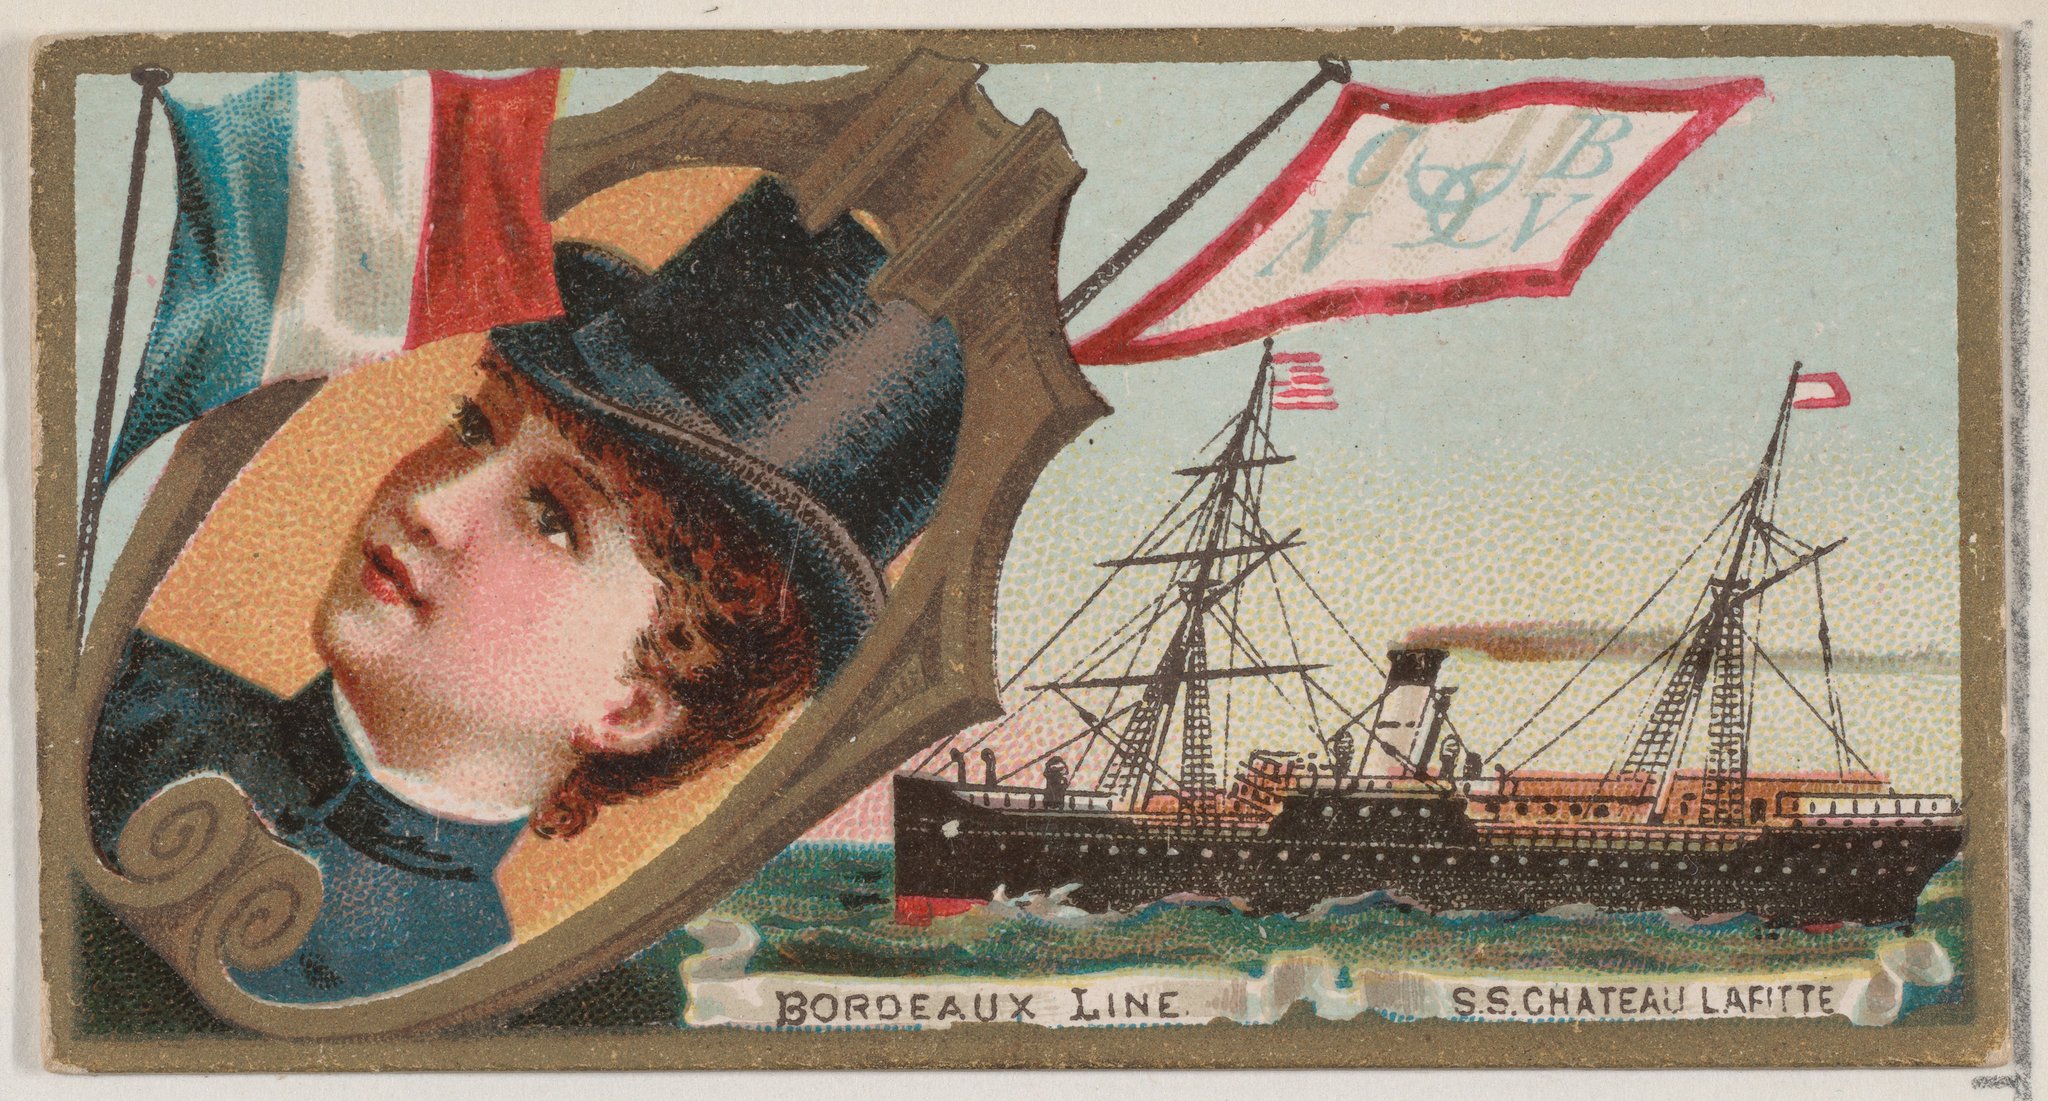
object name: print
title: Steamship Chateau Lafitte, Bordeaux Line, from the Ocean and River Steamers series (N83) for Duke brand cigarettes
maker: w. duke, sons & co.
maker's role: publisher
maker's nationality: american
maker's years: 1870-1920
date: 1887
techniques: color lithograph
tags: women,ships